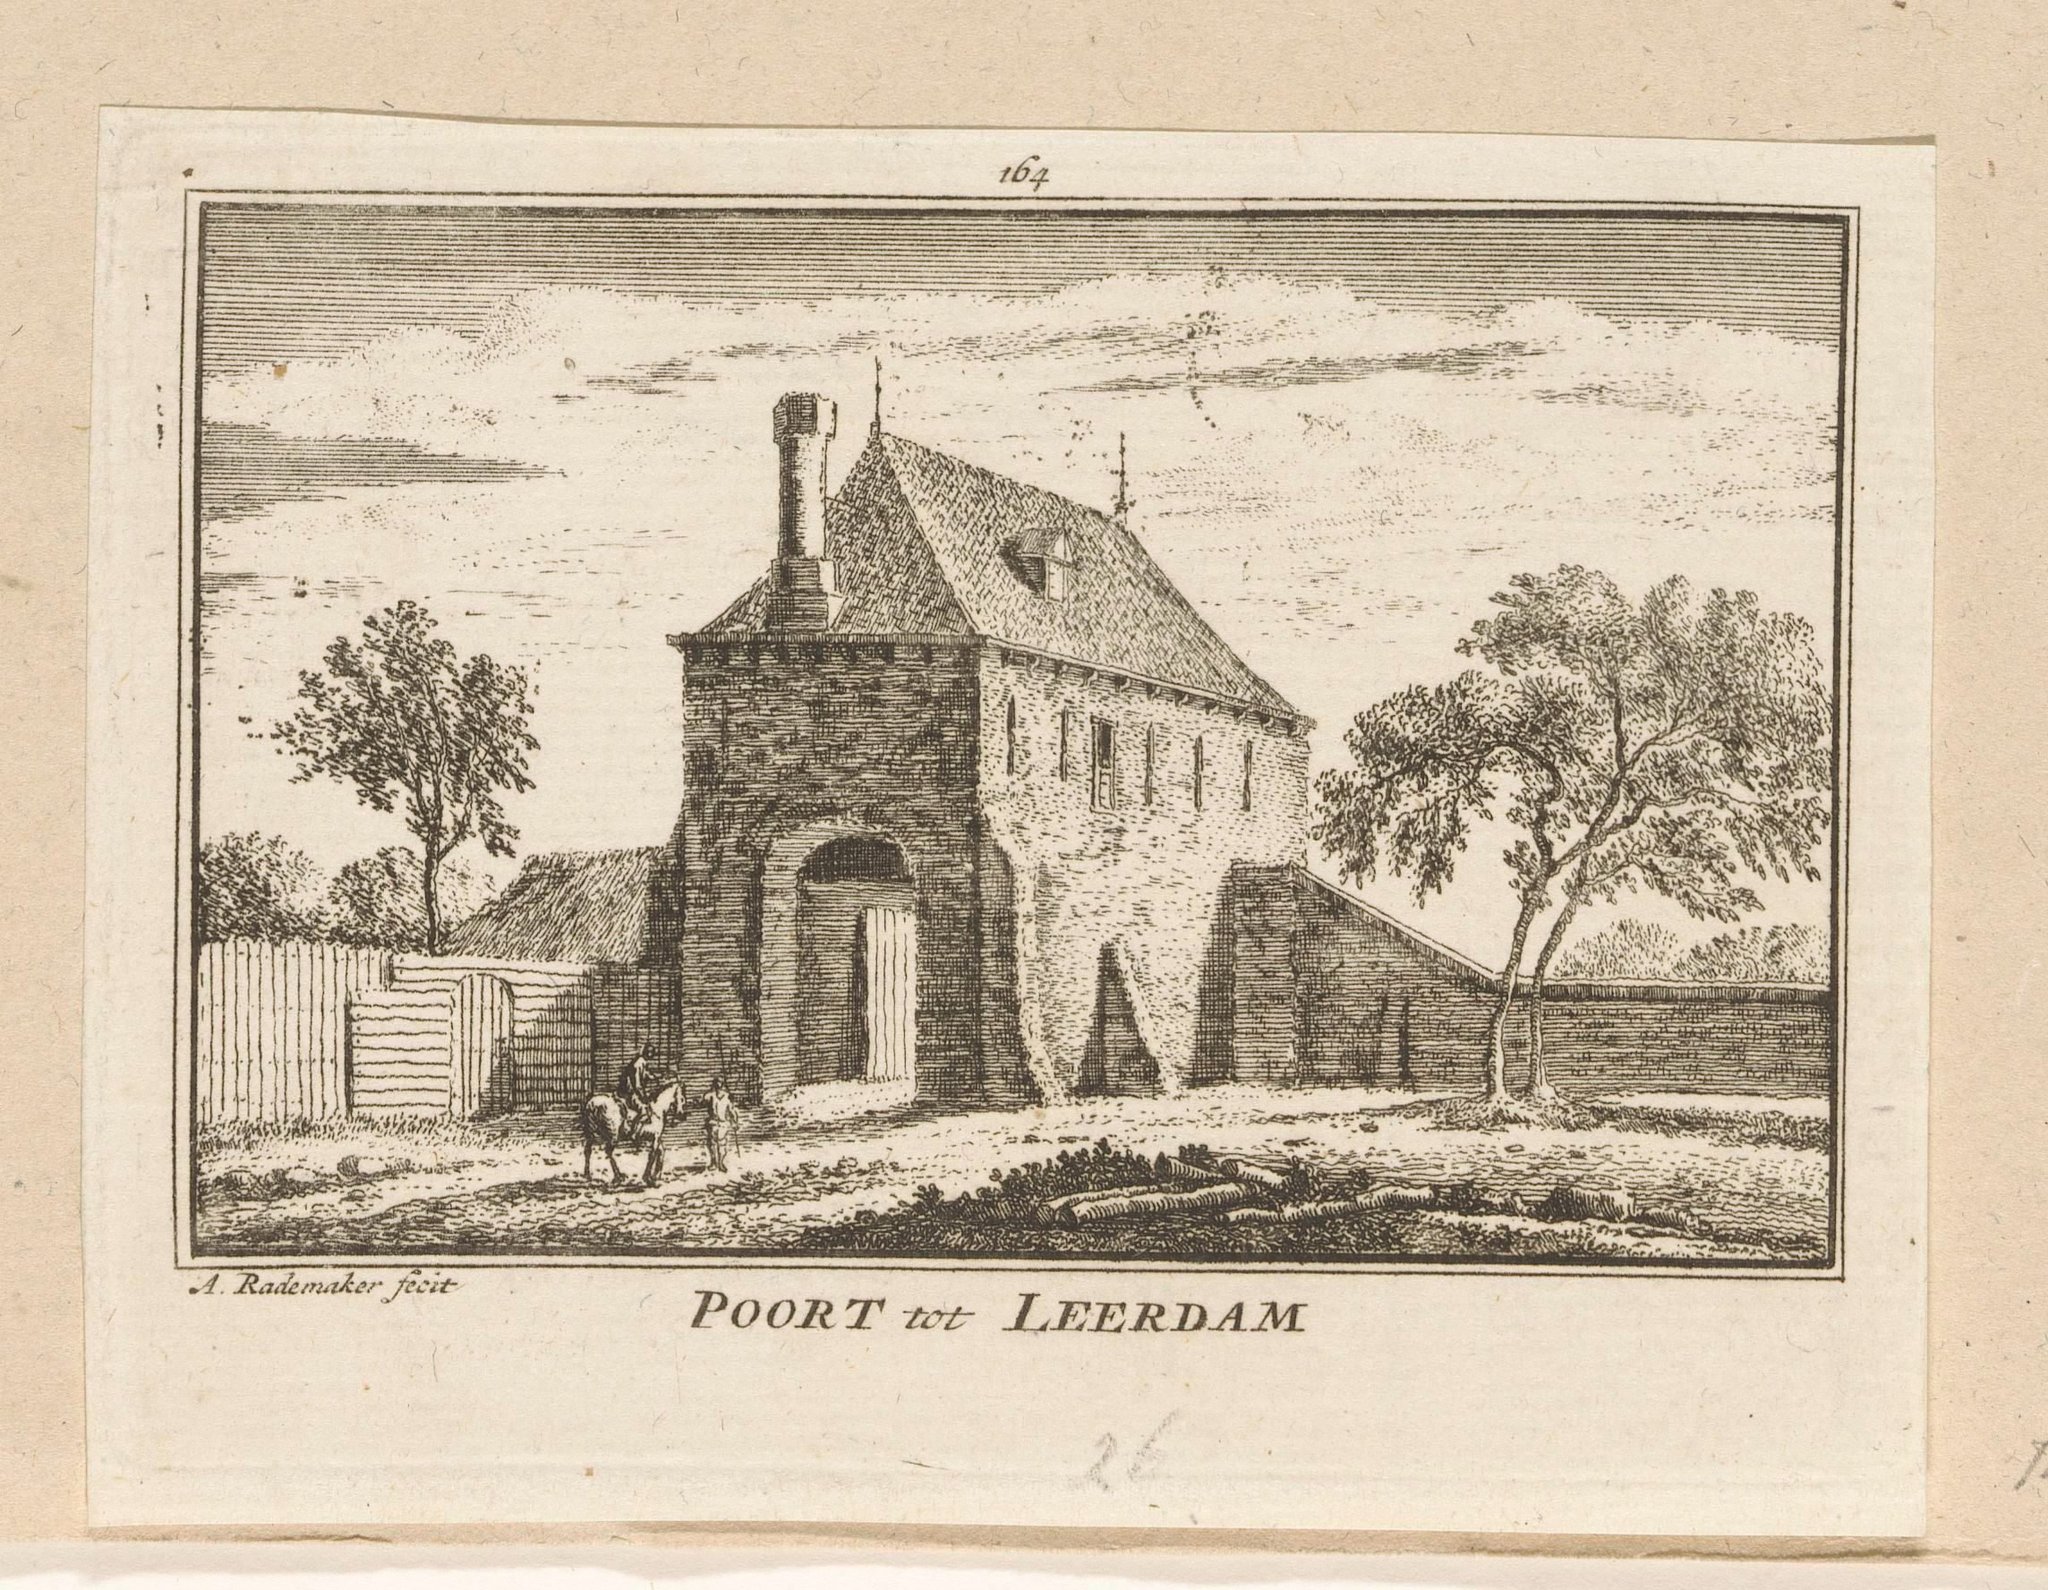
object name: print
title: Gezicht op een stadspoort te Leerdam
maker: abraham rademaker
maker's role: draughtsman, print maker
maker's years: 1676-1735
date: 1725-1803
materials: paper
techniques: engraving, etching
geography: amsterdam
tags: riding a horse, ass, or mule; rider, horseman, city-gate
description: Prent ook gebruikt in: Rademaker, Abraham. Kabinet van Nederlandsche outheden en gezichten: vervat in 300 konstplaaten (…). 2 delen. Amsterdam: Willem Barents, 1725, dl. 2, ill. 164. Na 1725 is deze prent nog in verschillende heruitgaven verschenen, uitgegeven in 1727-1733, 1770-1771 en 1792-1803. Uit welke uitgave het huidige exemplaar precies komt is niet na te gaan.